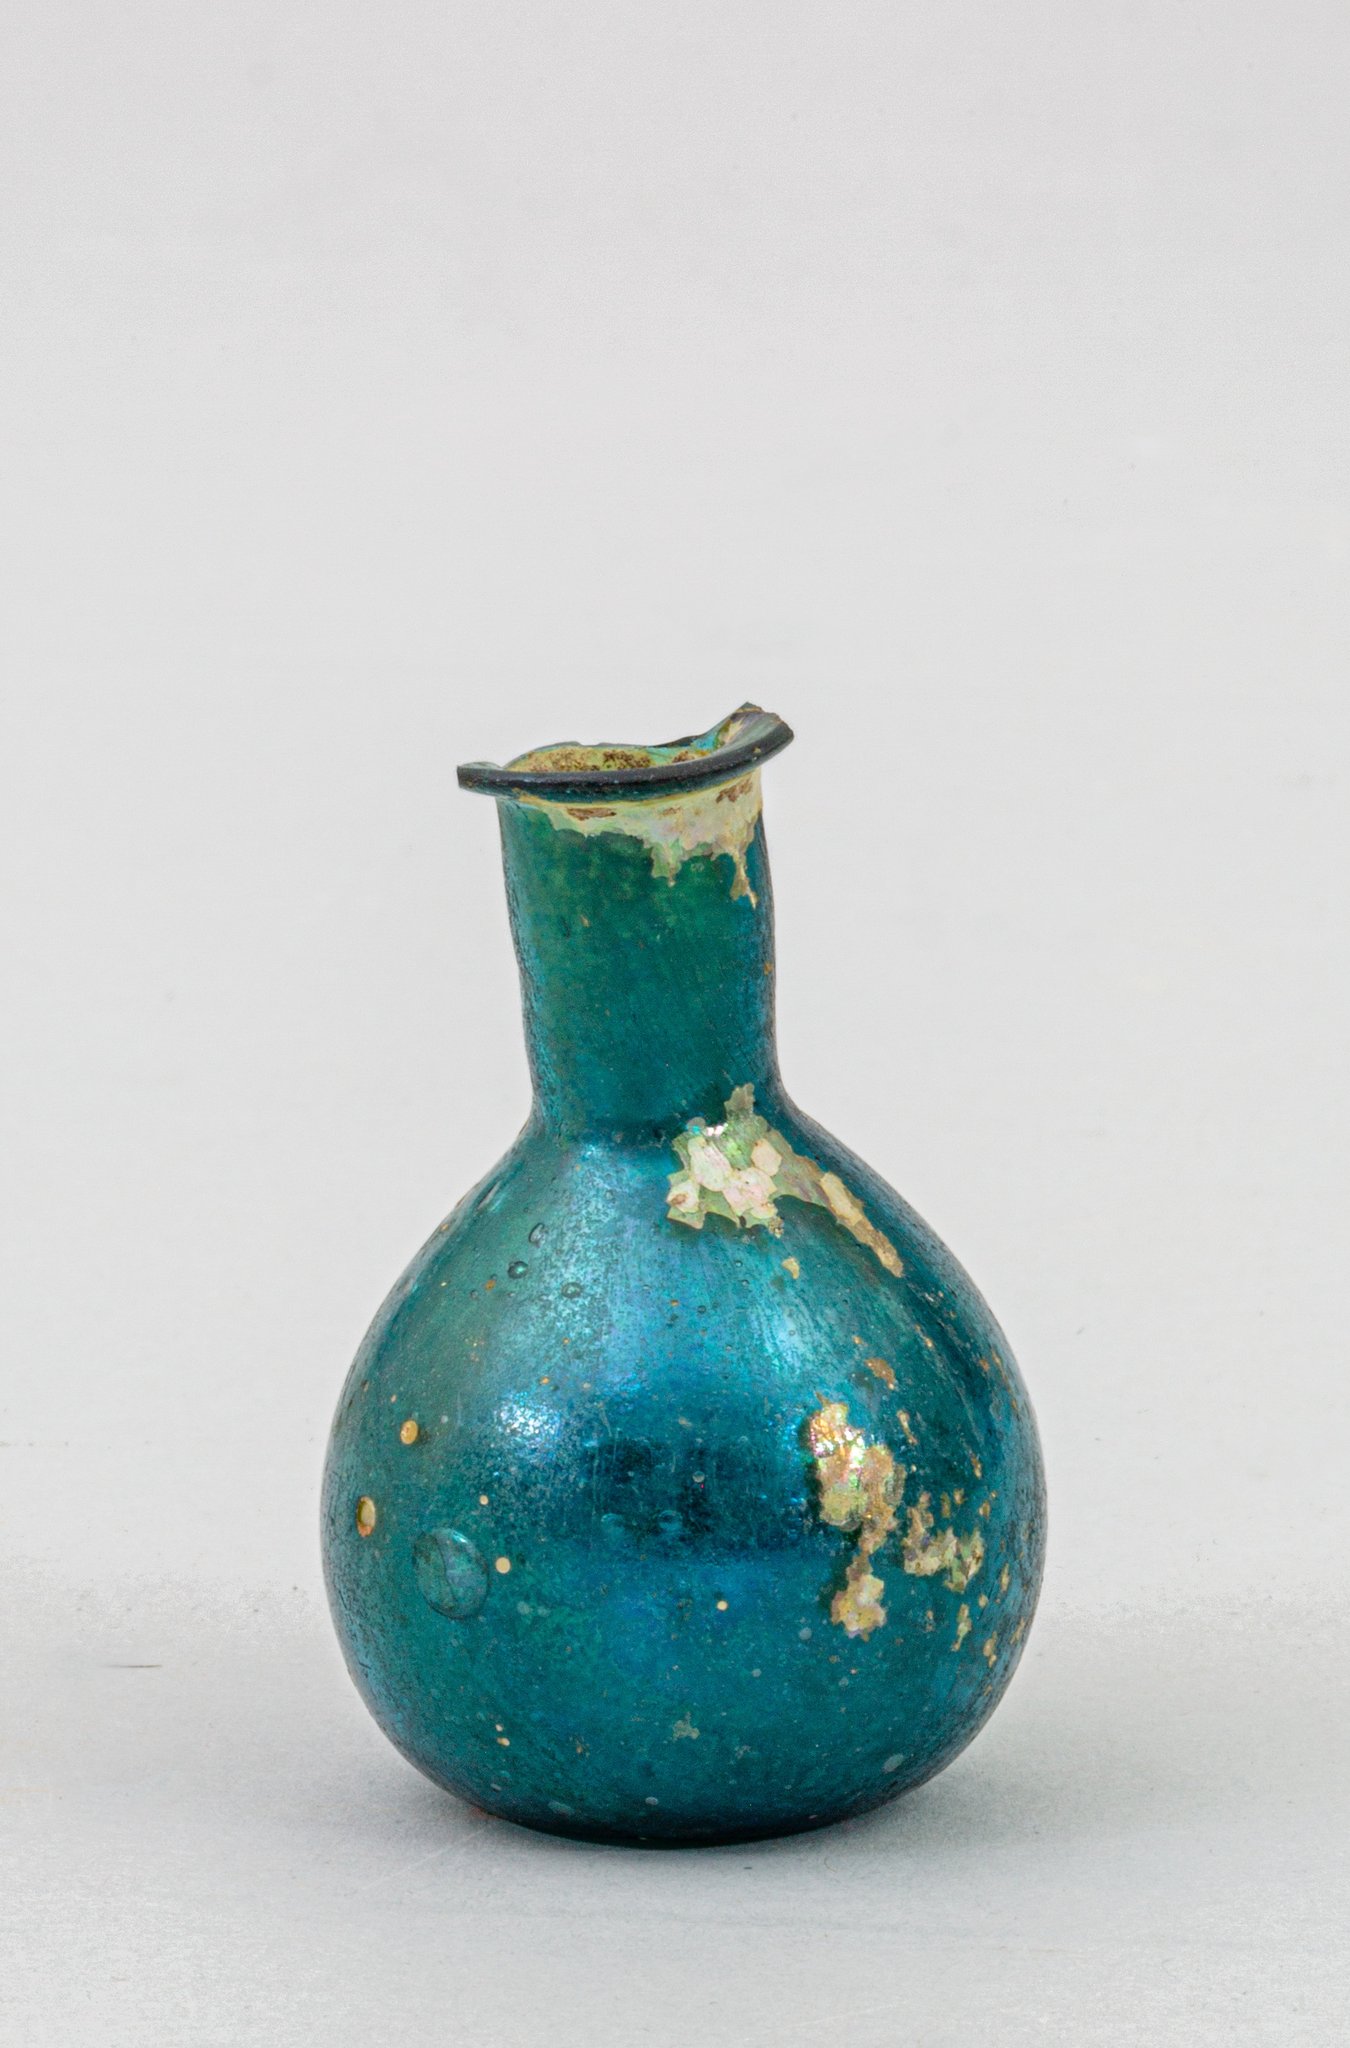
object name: perfume bottle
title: Glass perfume bottle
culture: roman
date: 1-50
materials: glass